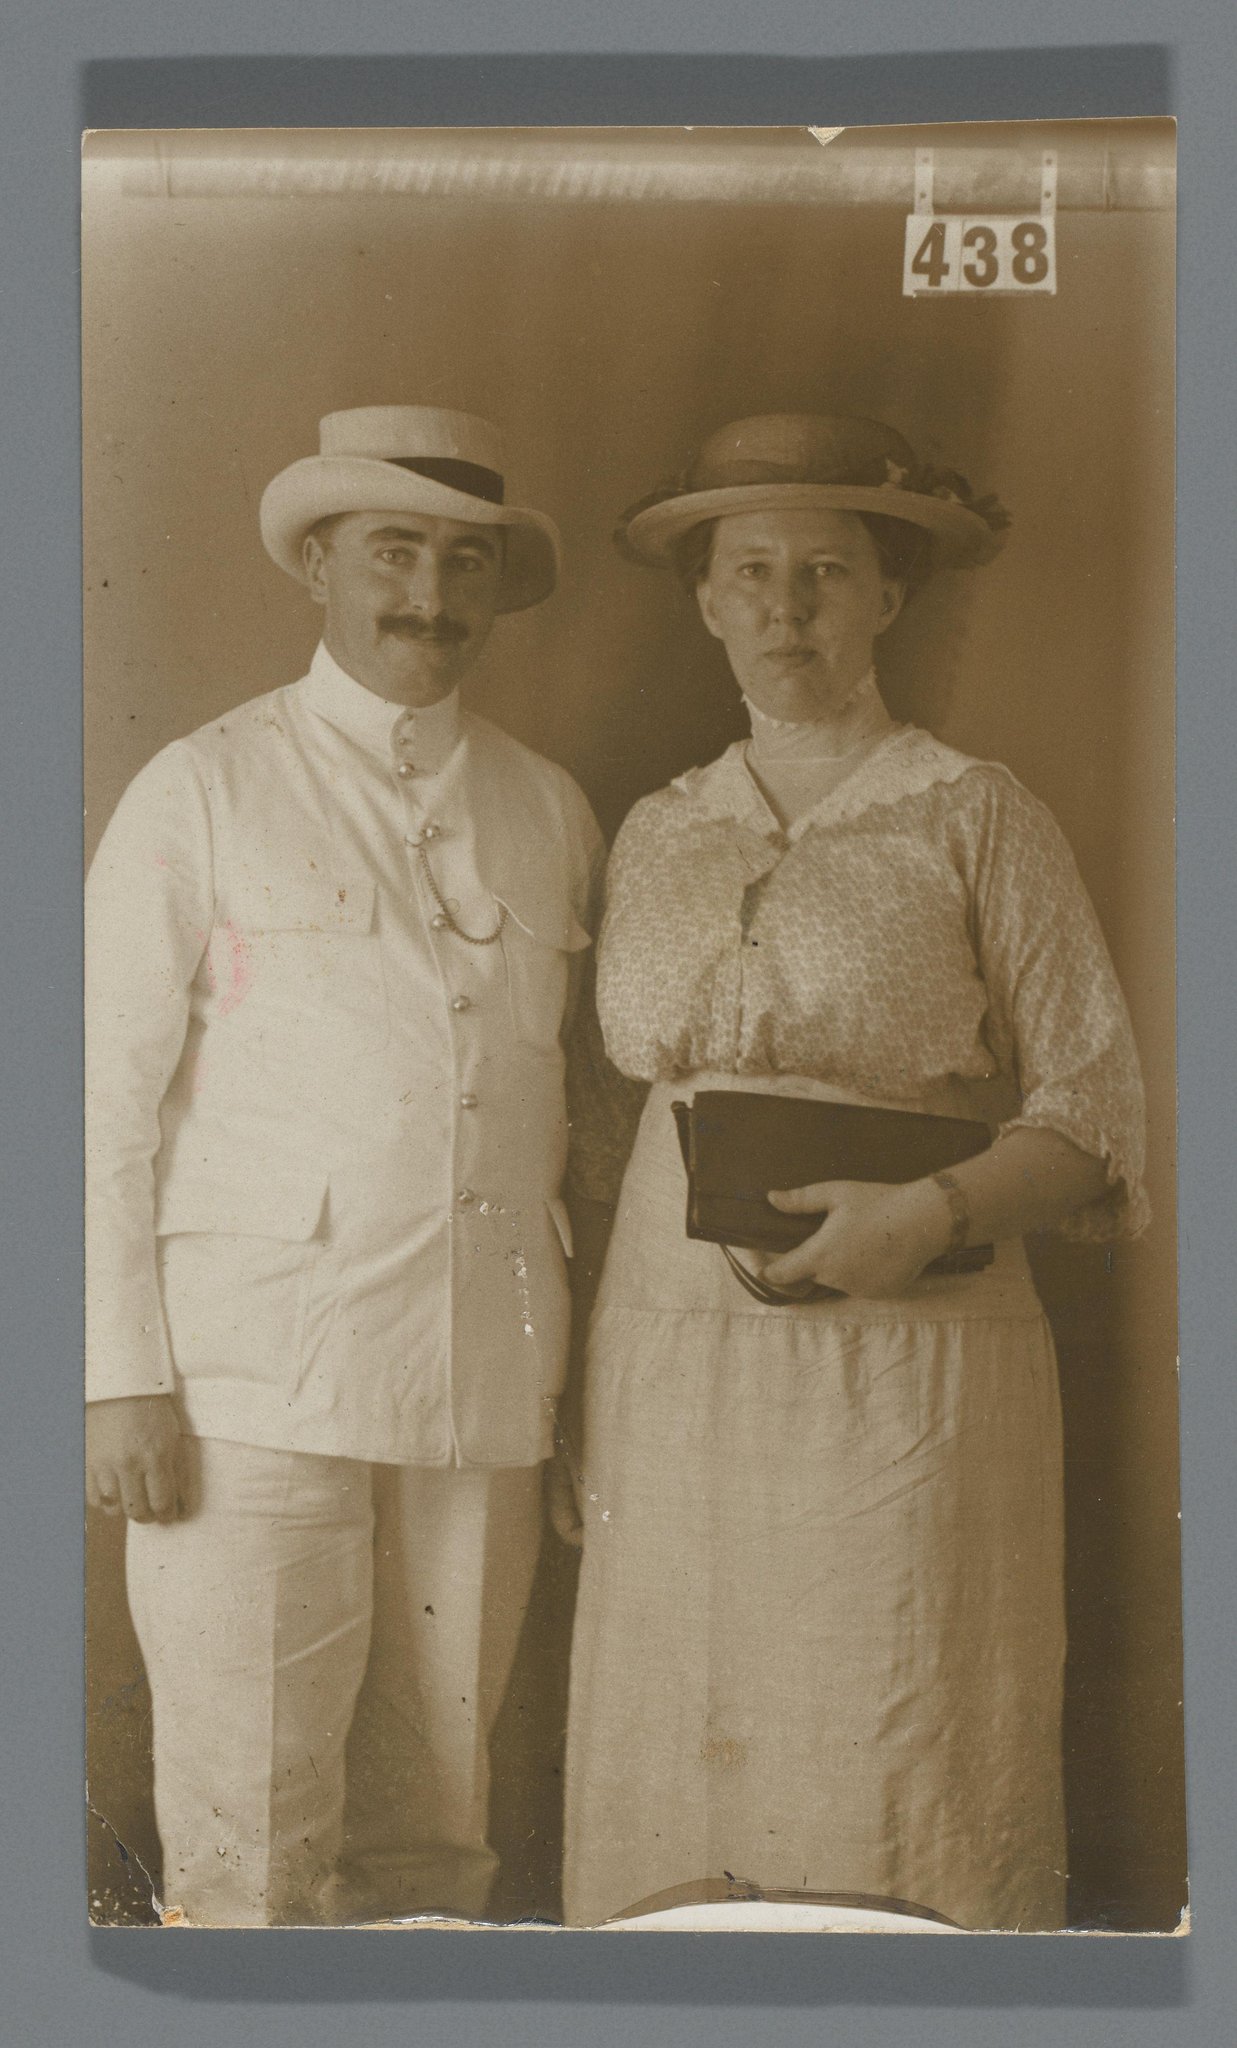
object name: snapshot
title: Rapid photographs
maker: Anonymous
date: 1912-1918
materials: paper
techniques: gelatin silver print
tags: adult woman, adult man, anonymous historical person portrayed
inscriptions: number: ‘438’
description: Between 1912 and 1930, anyone could have their portrait taken at the many so-called rapid photography studios in the shopping streets of mainly (medium) large-size European cities. As if on an assembly line, the youngest clerk shot the photographs with a special camera and in artificial light and developed them. Later in the day, the customer collected a sheet with 12 portrait photos for 25 cents. This form of photographic mass production gave rise to a fascinating tableau of boys, girls, men and women not previously seen in photographs; candid and informal. There were at least 150 quick-photo studios, from Alkmaar to Zutphen. Many called themselves ‘American,’ mistakenly as it turns out because hardly any examples from that country have been found.